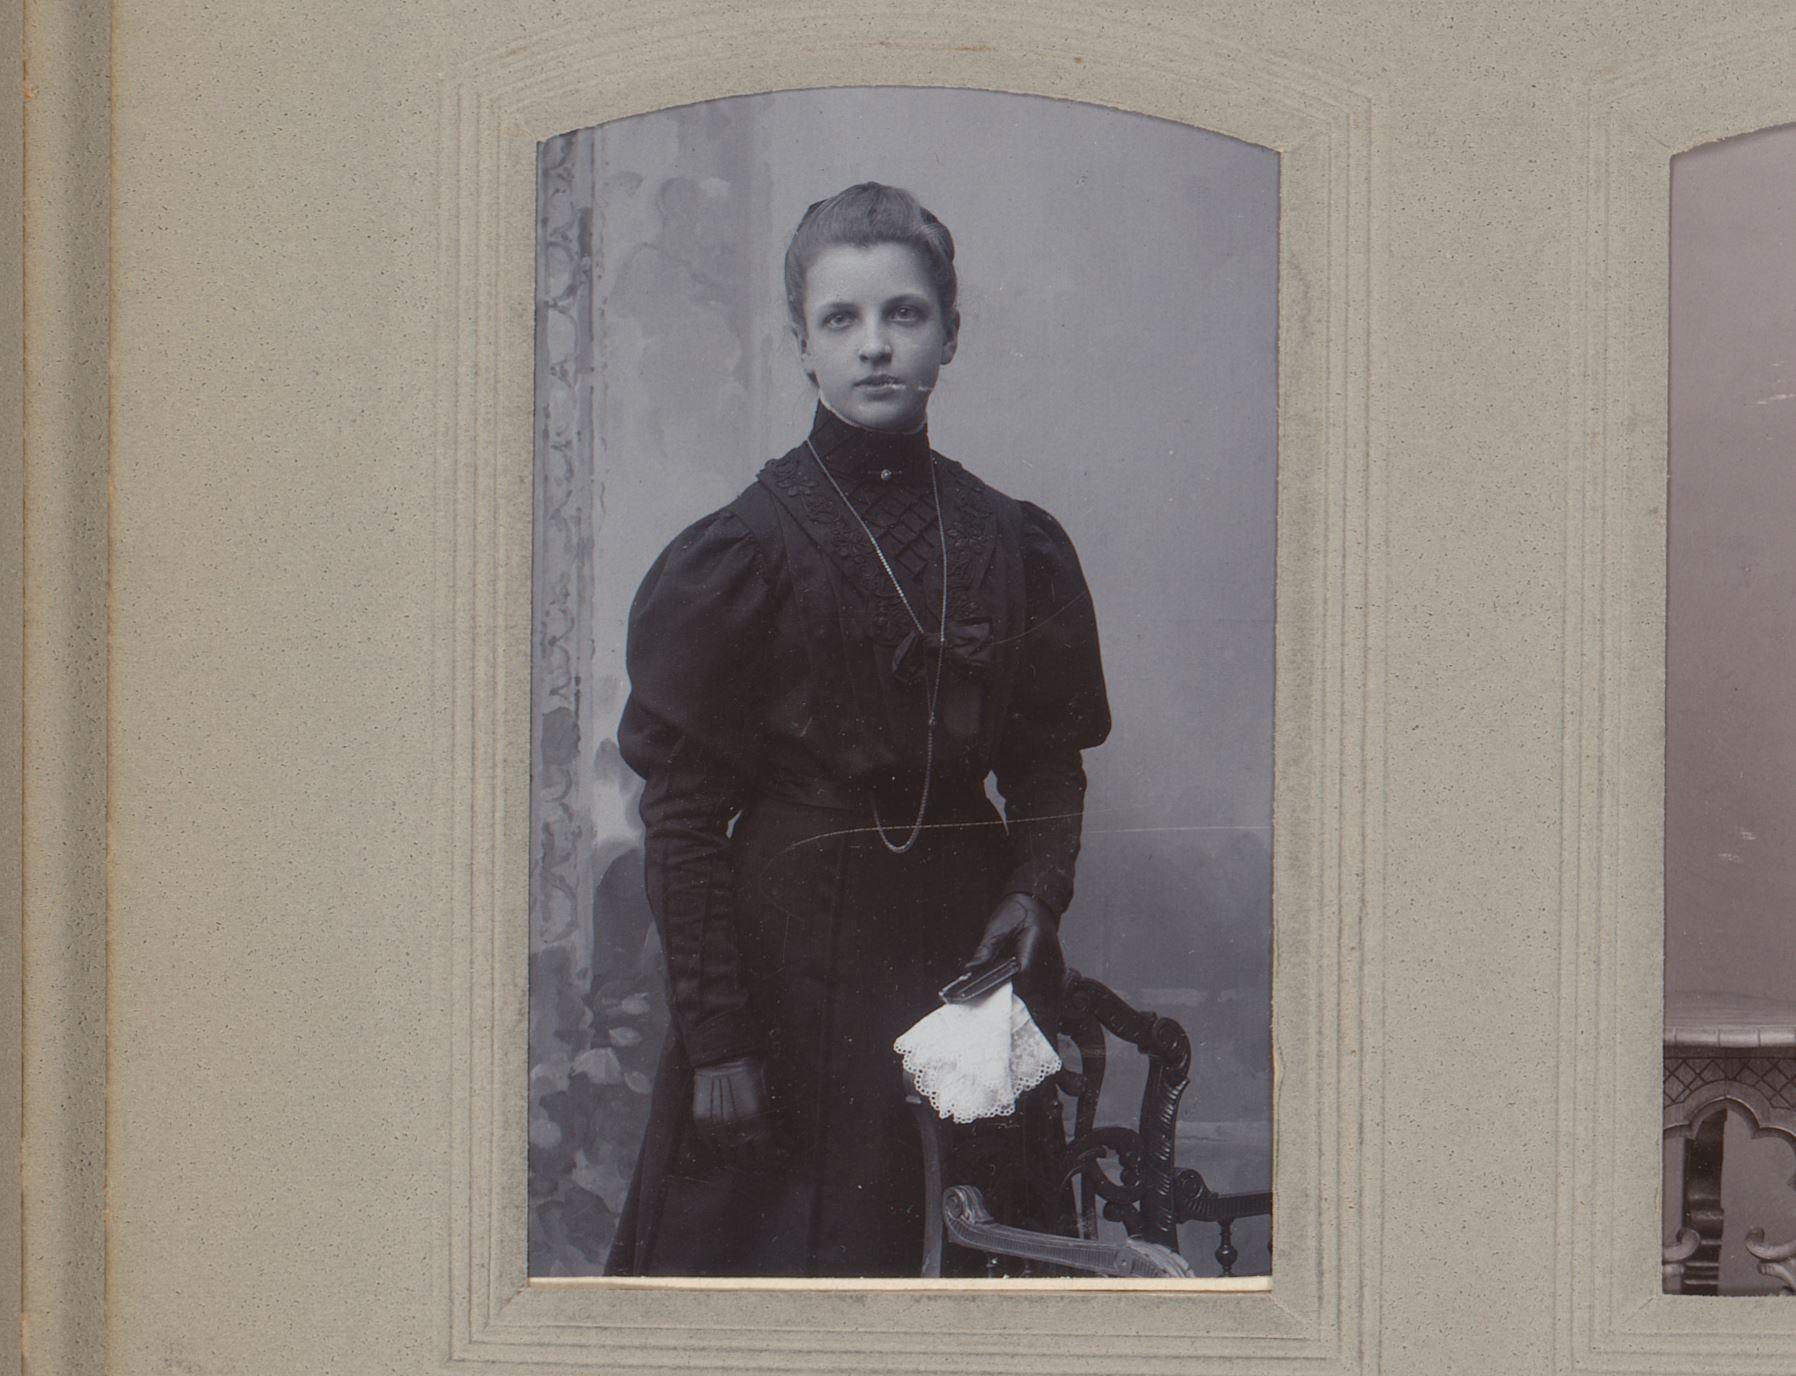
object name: carte de visite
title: Portret van een staande jonge vrouw in zwarte jurk met boek en witte zakdoek in de hand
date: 1880-1920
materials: cardboard, photographic support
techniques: collodion silver print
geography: stockholm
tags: adolescent, young woman, maiden, historical persons - bb - woman, handkerchief, book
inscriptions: inscription: ‘Karlsson & Bergström/ Stockholm/ Vasagatan 20.’